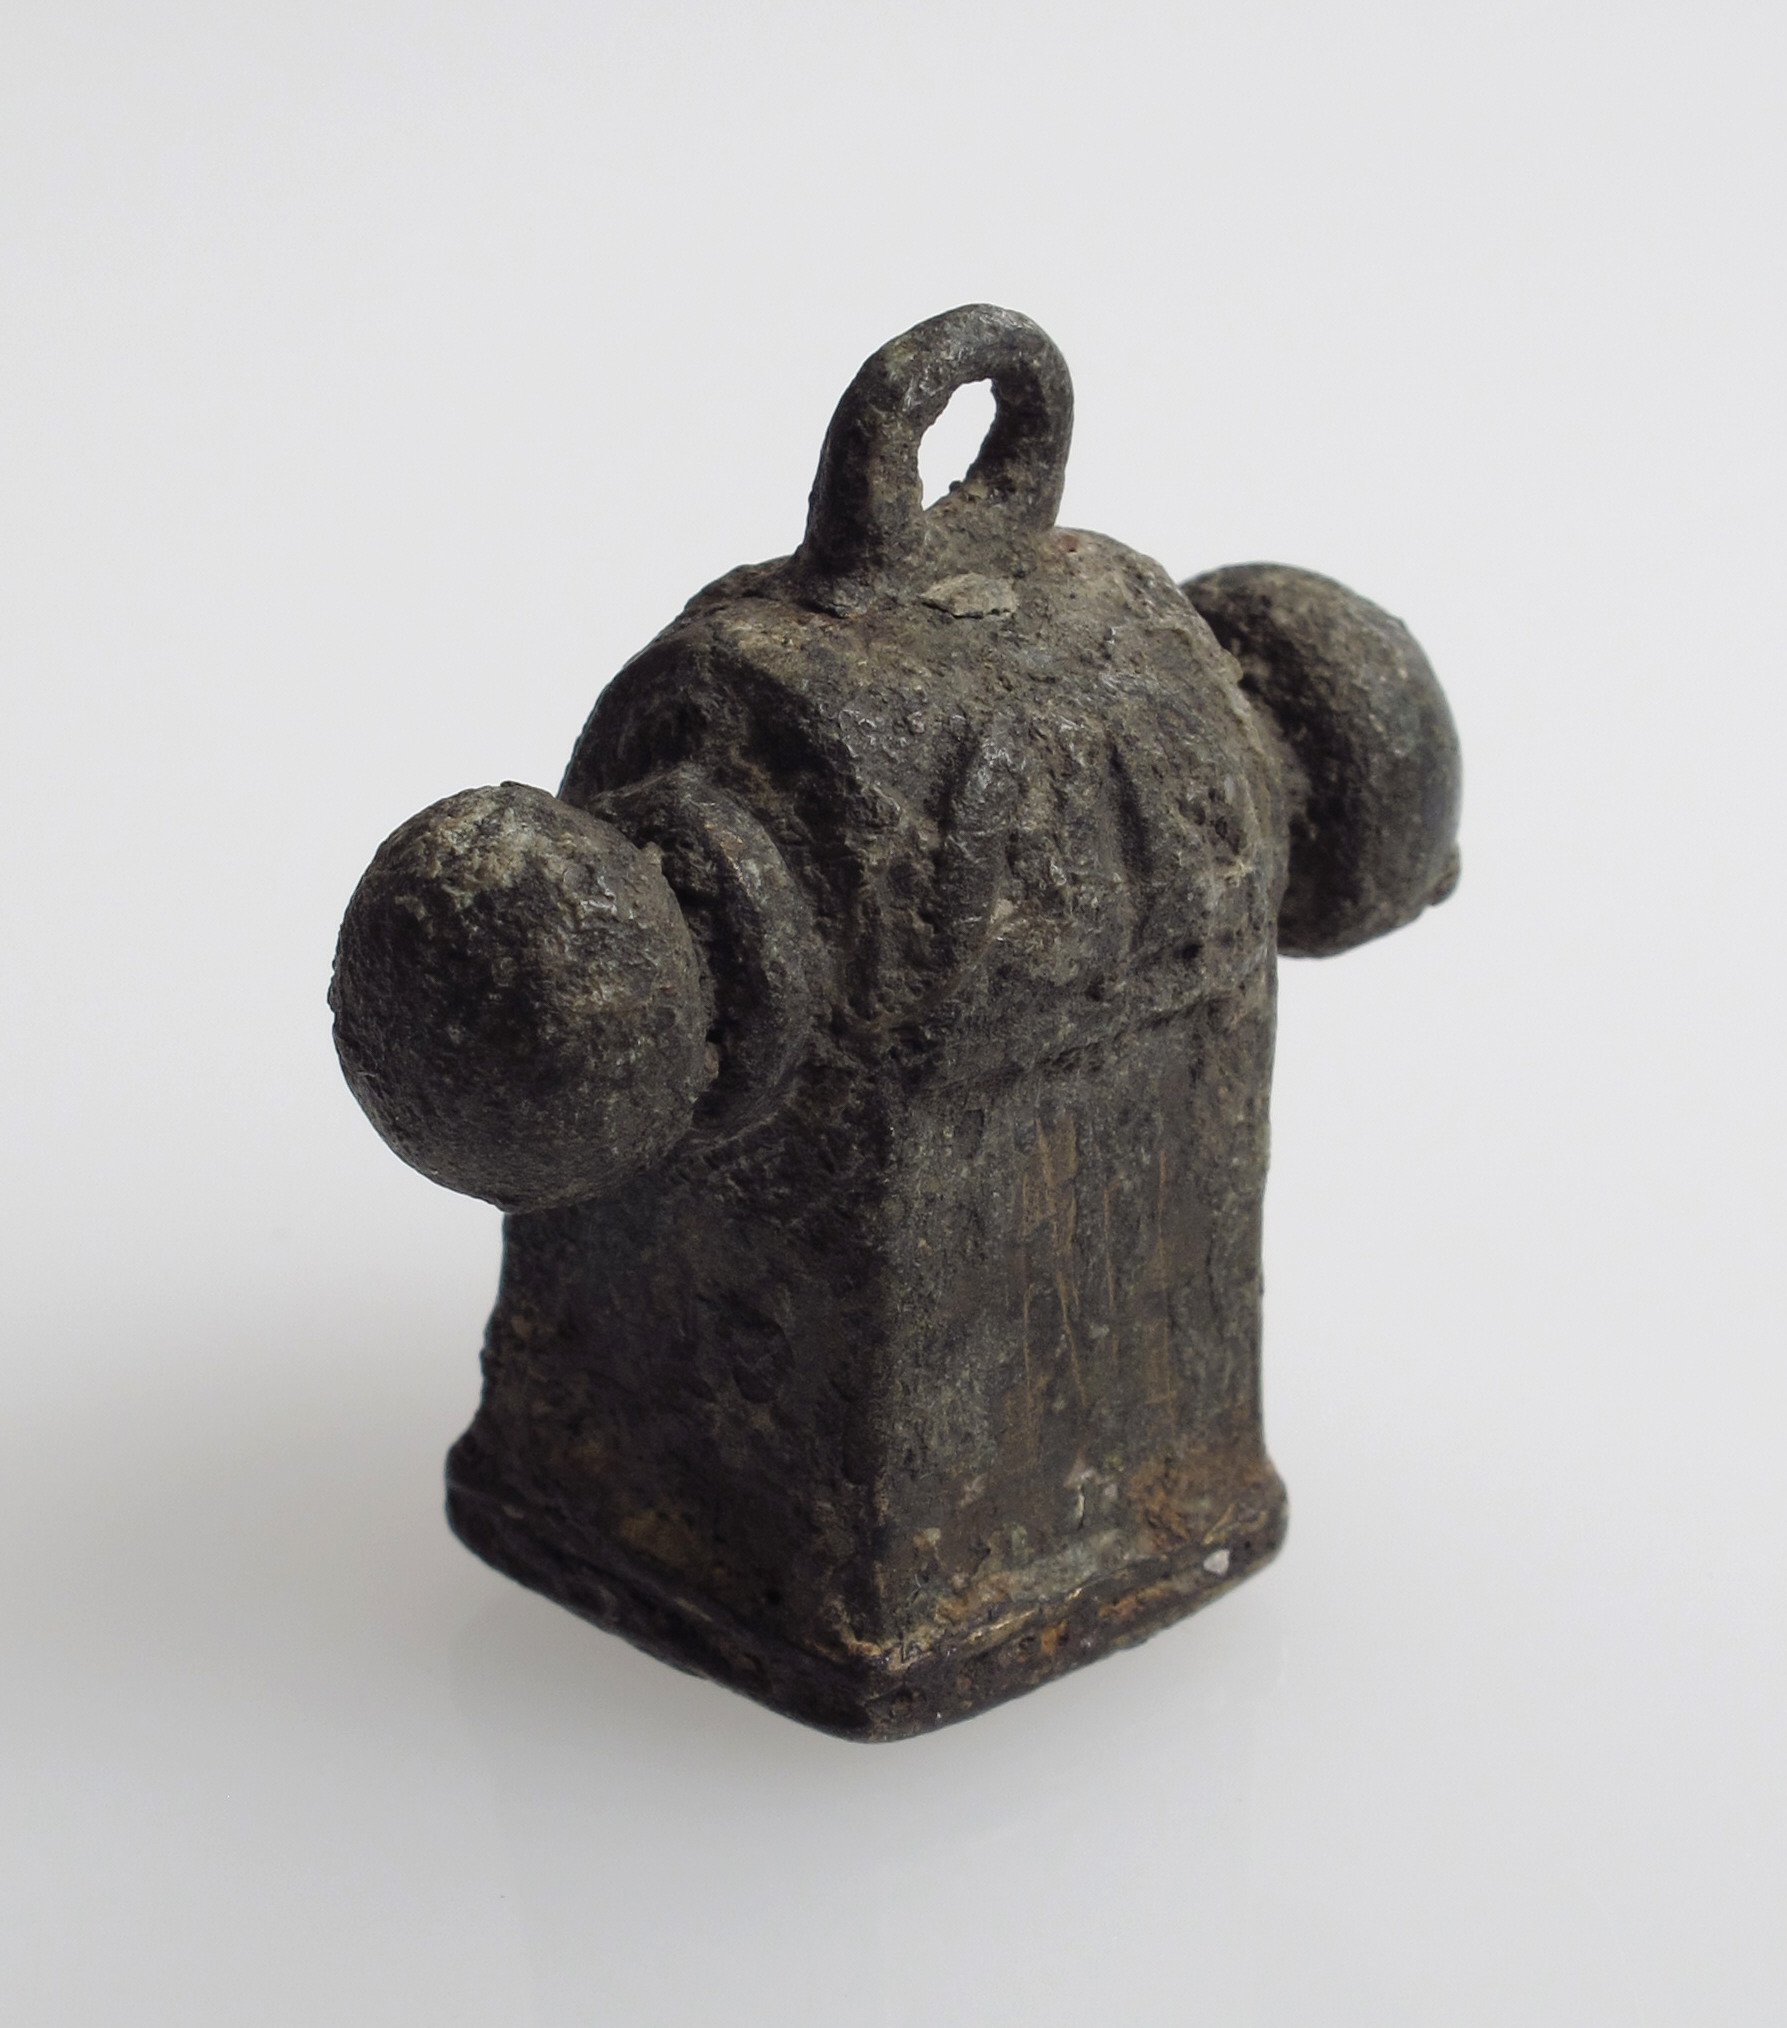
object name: key handle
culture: roman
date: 1-700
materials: copper alloy